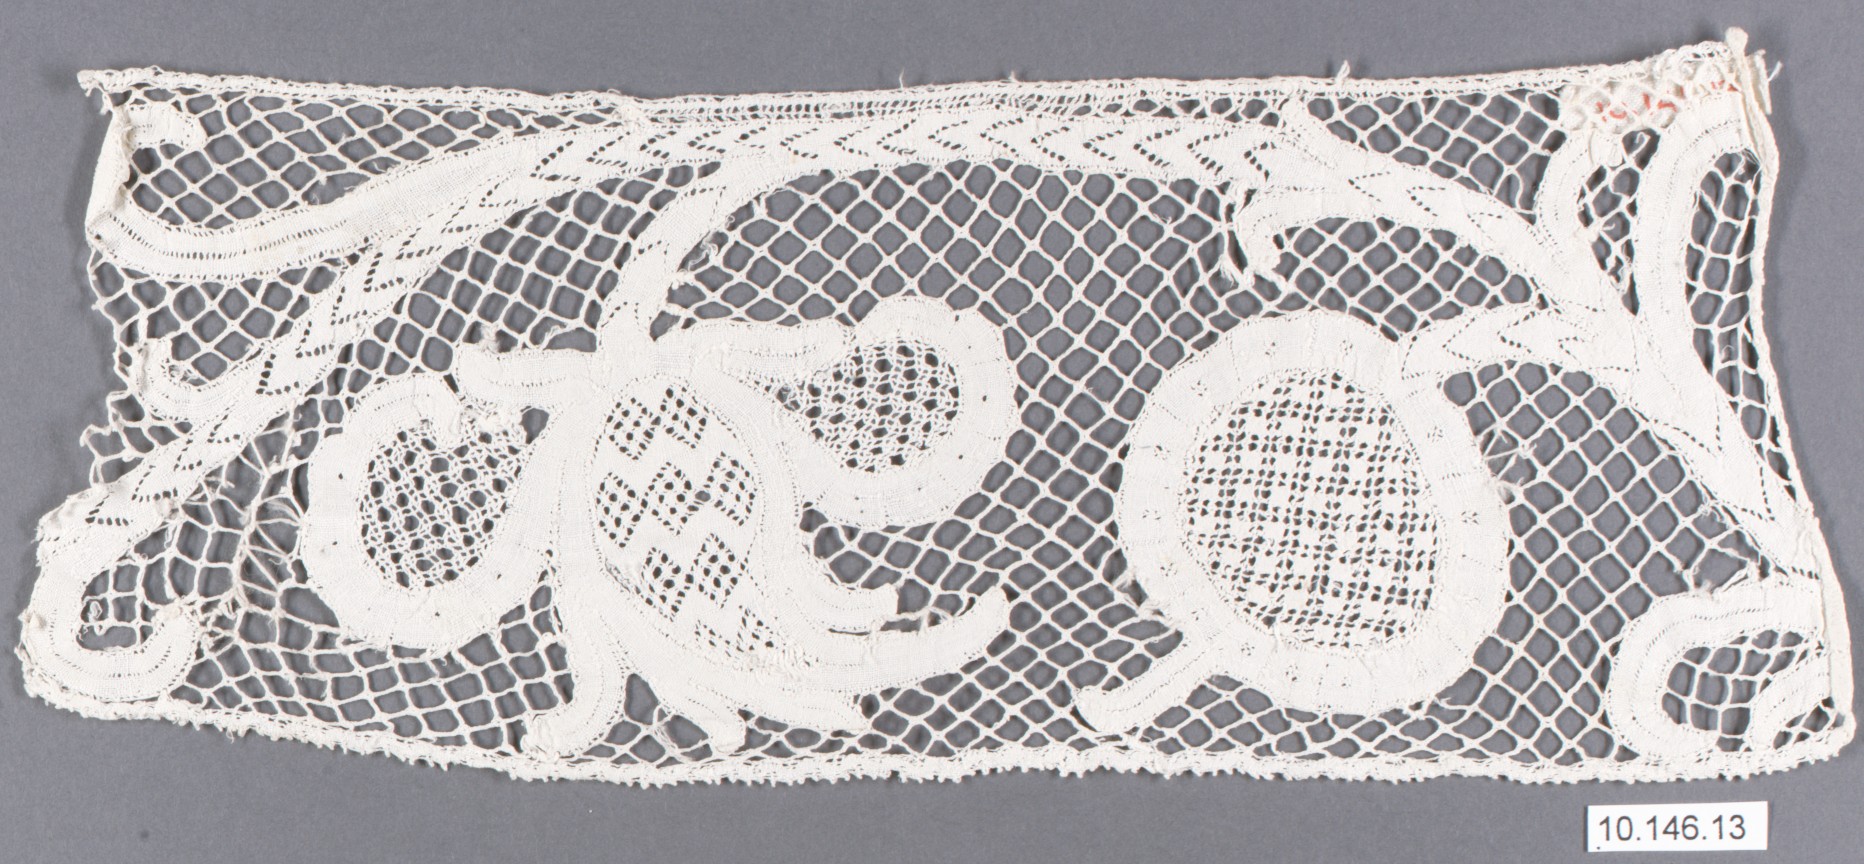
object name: fragment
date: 1701-1800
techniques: lace